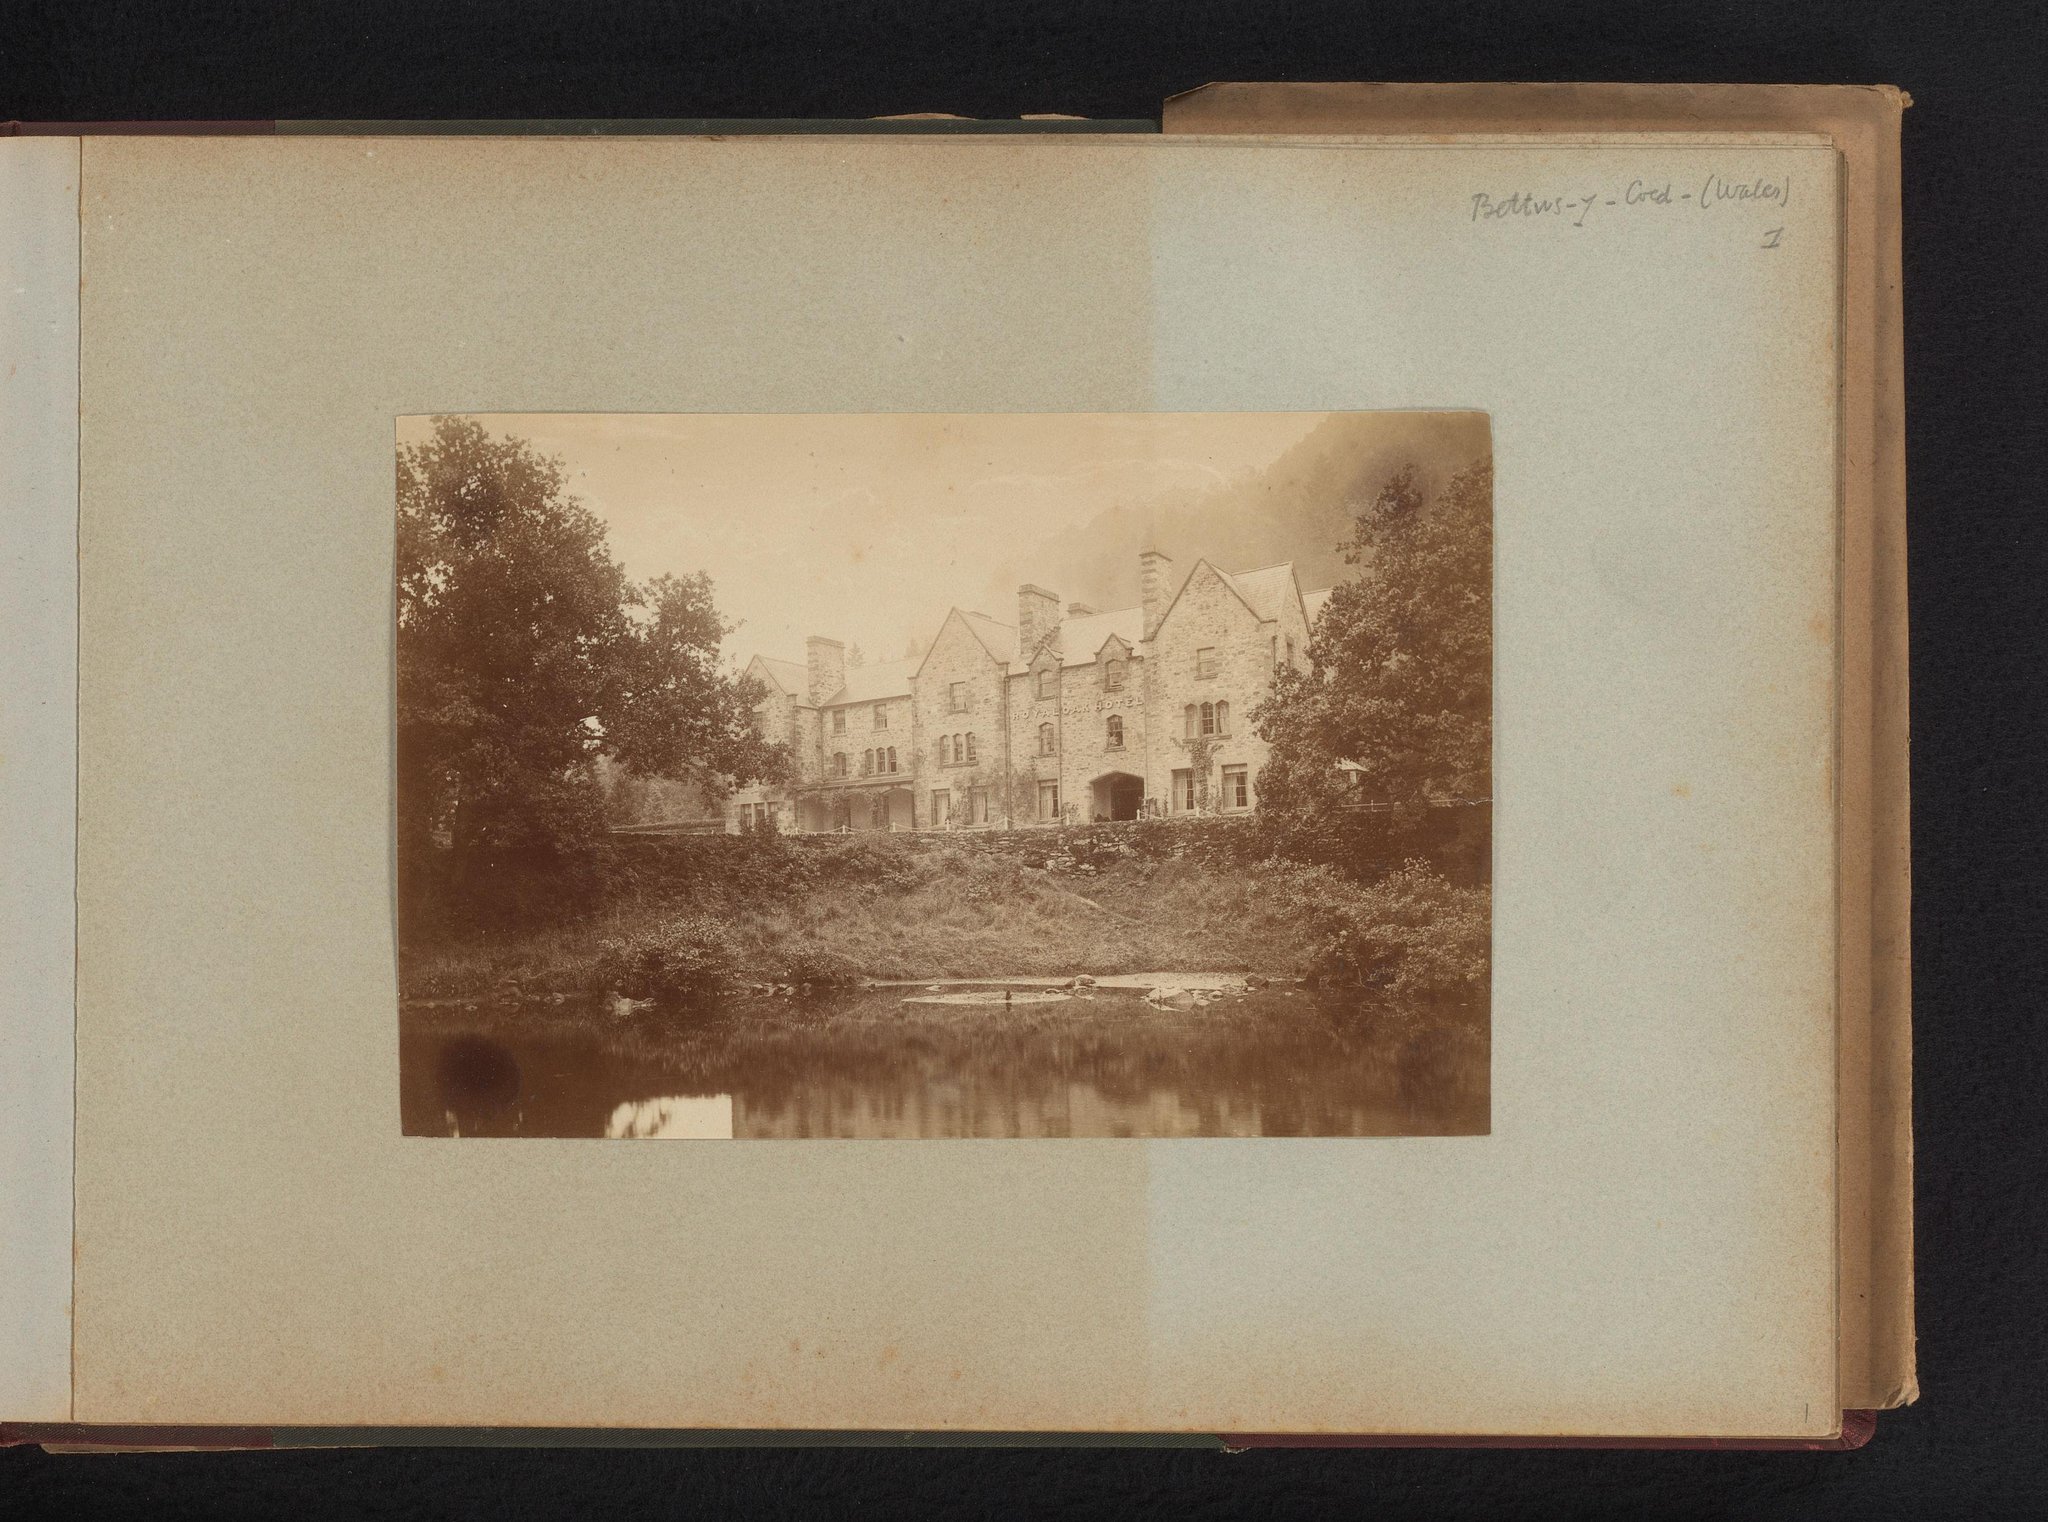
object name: album leaf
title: Gezicht op het Royal Oak Hotel in Betws-y-Coed, Wales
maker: Anonymous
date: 1851-1900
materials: paper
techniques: albumen print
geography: bettws-y-coed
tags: exterior ~ representation of a building, hotel, hostelry, inn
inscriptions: inscription: ‘Bettus-y-Coed (Wales)/ 1’